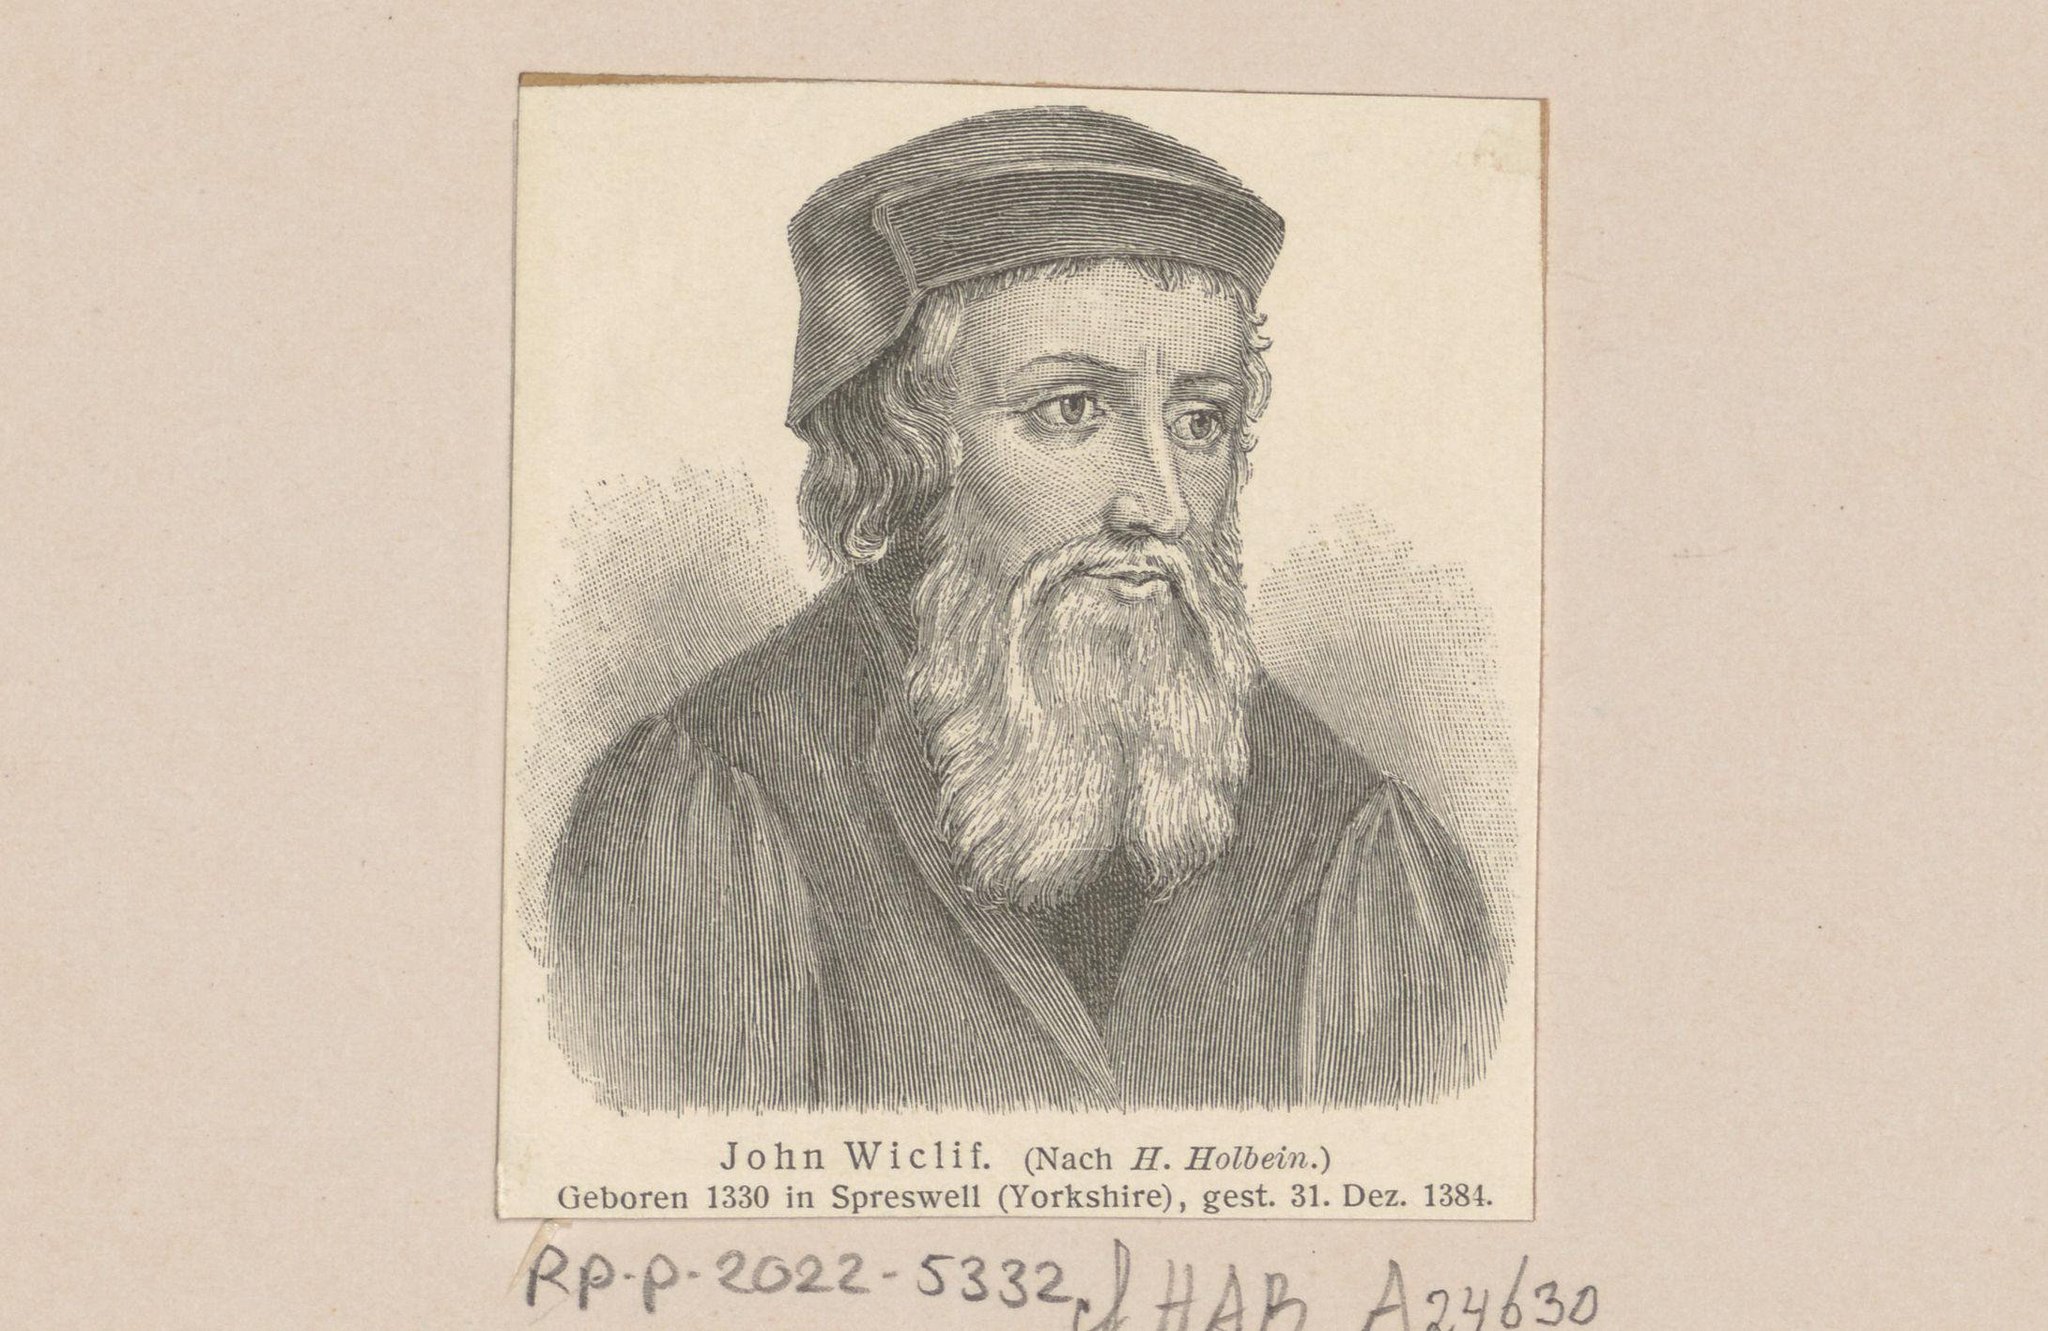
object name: print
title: Portret van John Wyclif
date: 1800-1899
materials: paper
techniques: letterpress printing, engraving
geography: germany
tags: theologian, historical persons